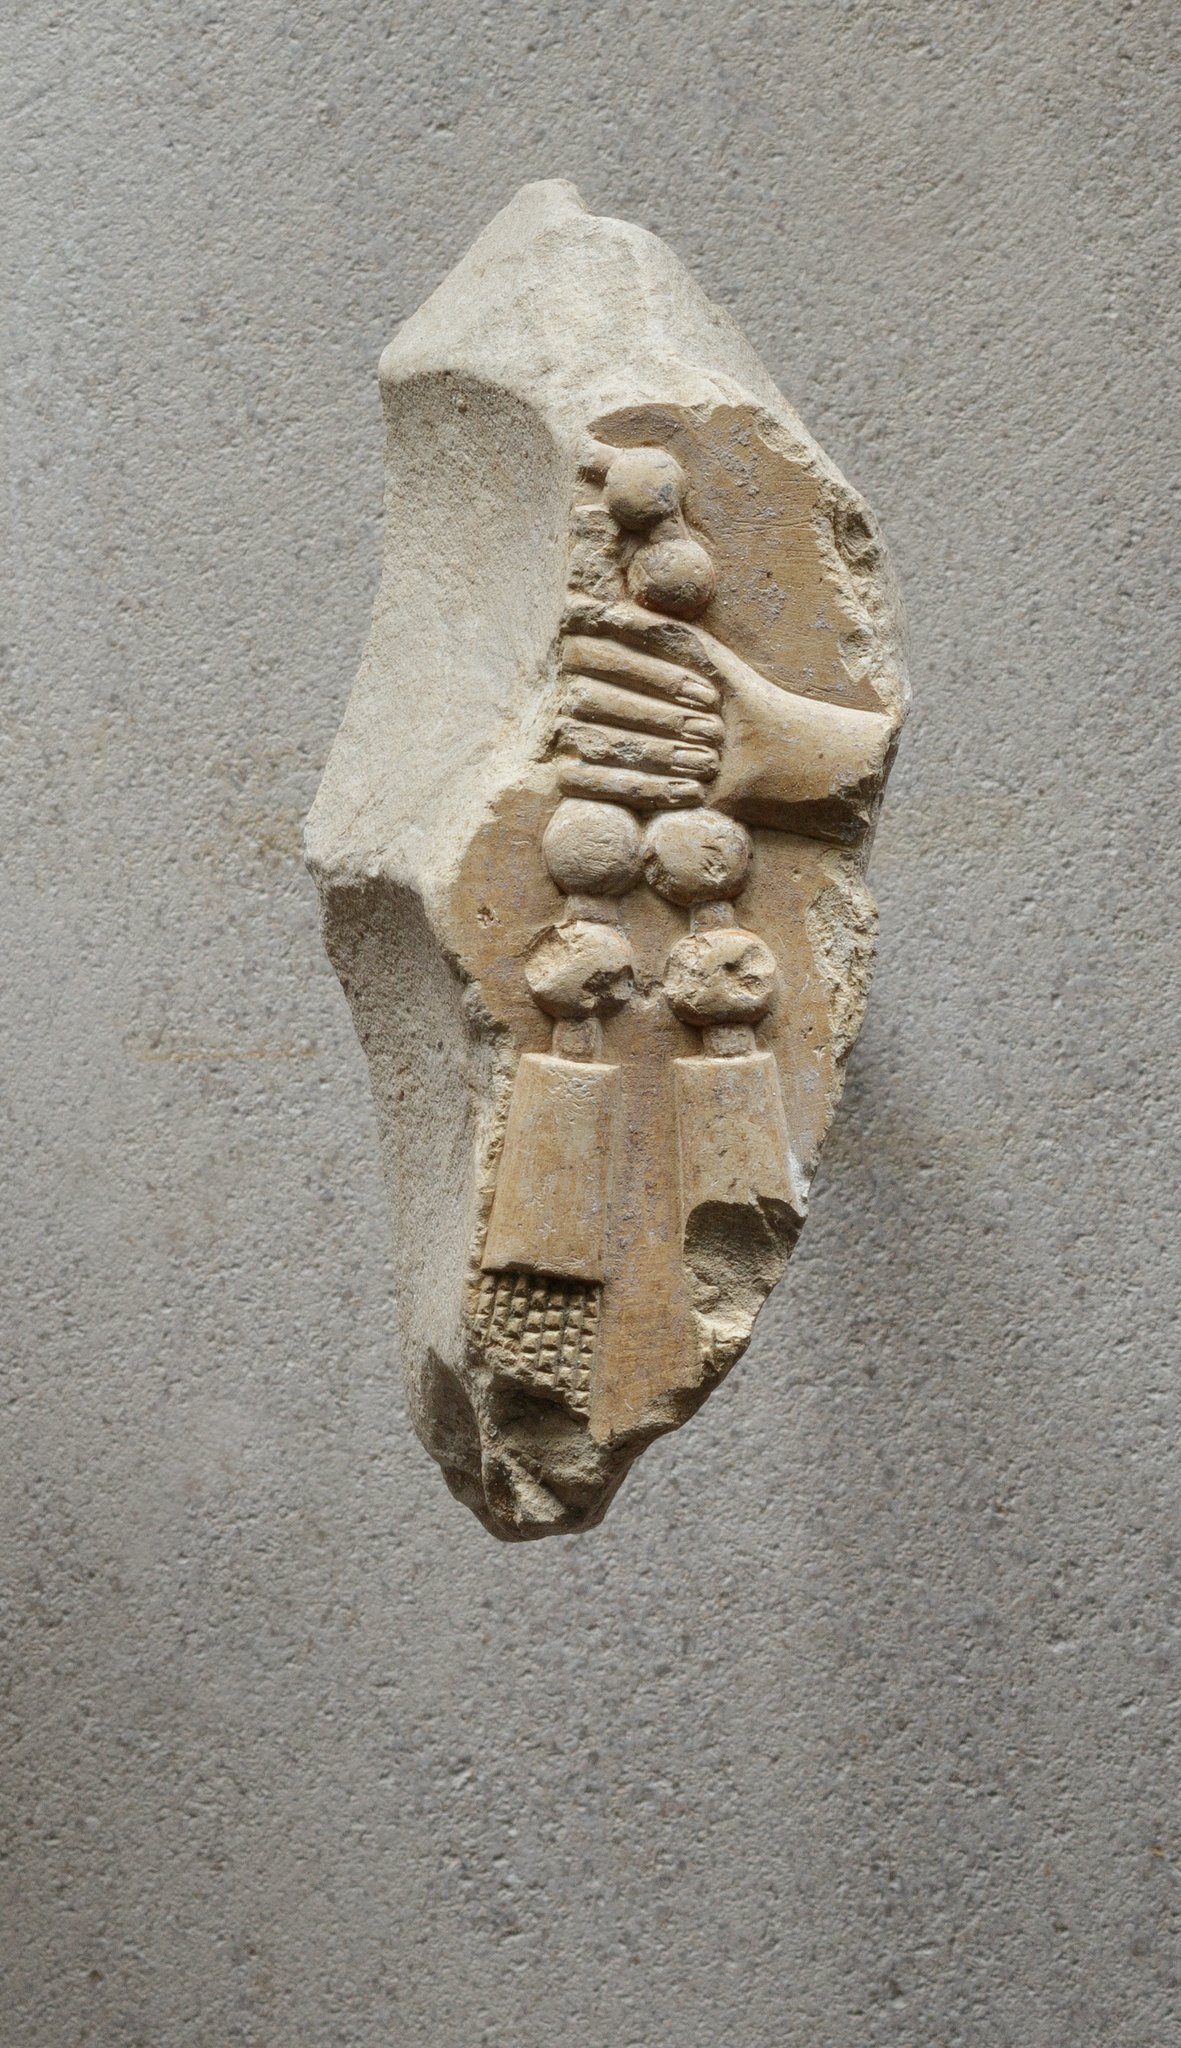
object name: relief fragment, tomb of neferu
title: Relief of a hand with part of necklace - see 26.3.353-3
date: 2051-2030 BCE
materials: limestone, paint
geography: egypt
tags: hands